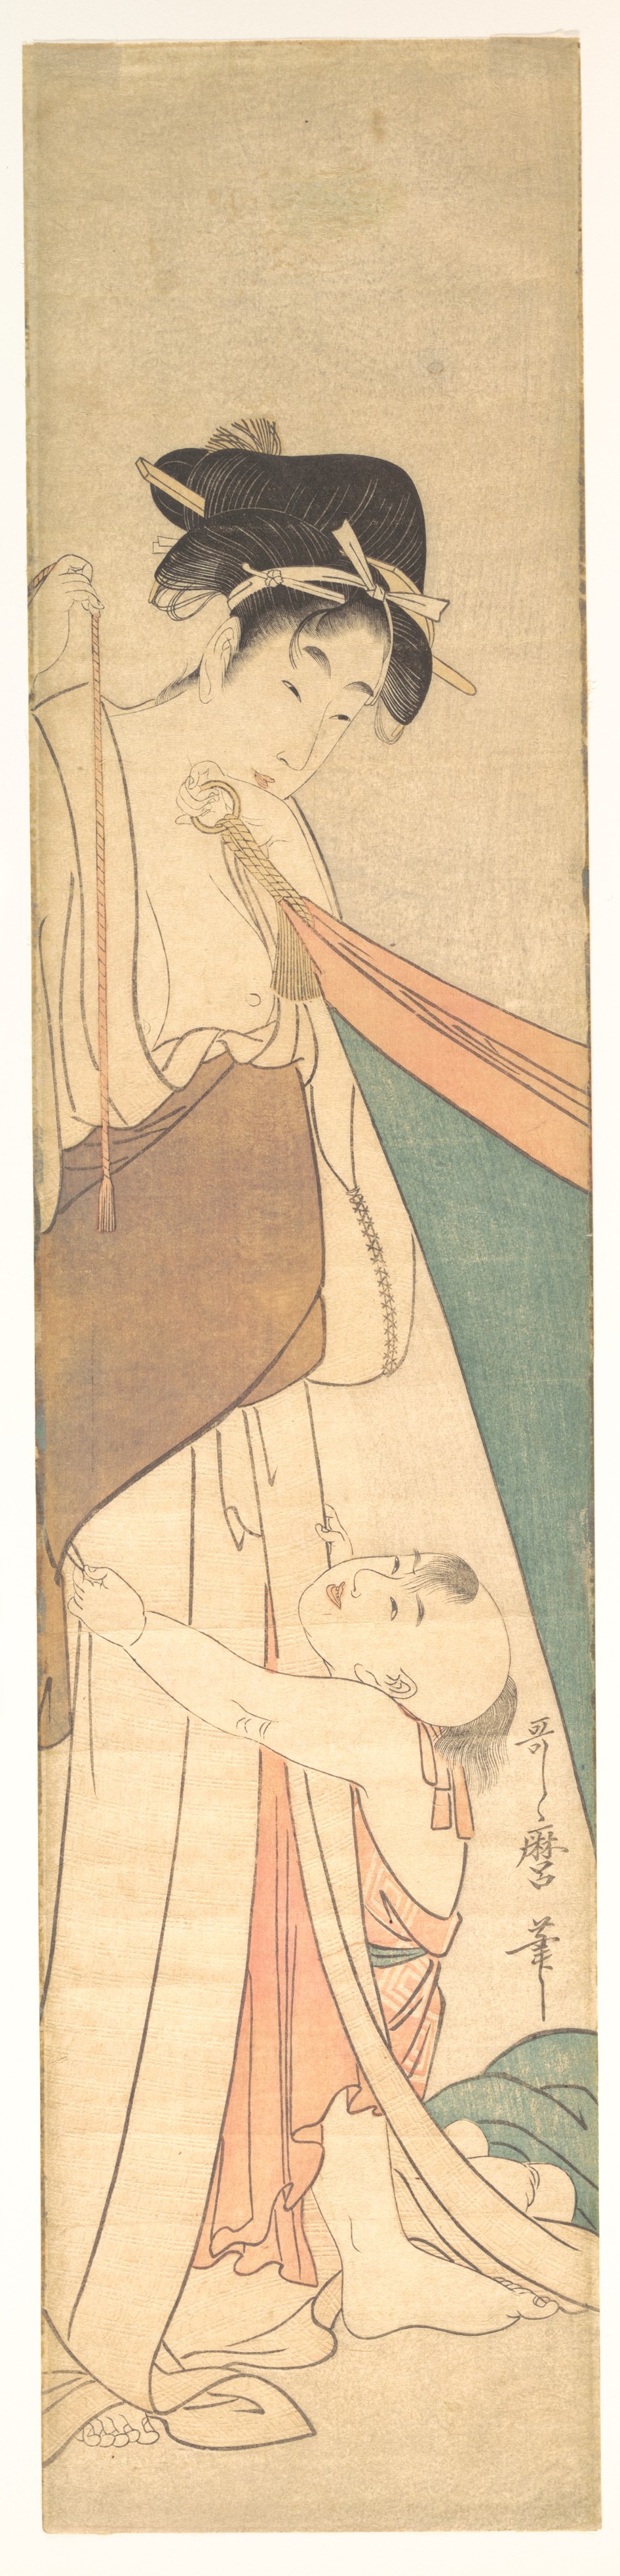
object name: print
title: Woman and Child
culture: japanese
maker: kitagawa utamaro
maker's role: artist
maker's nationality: japanese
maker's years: 1754-1806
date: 1795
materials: ink, paper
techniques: woodblock print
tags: children,women